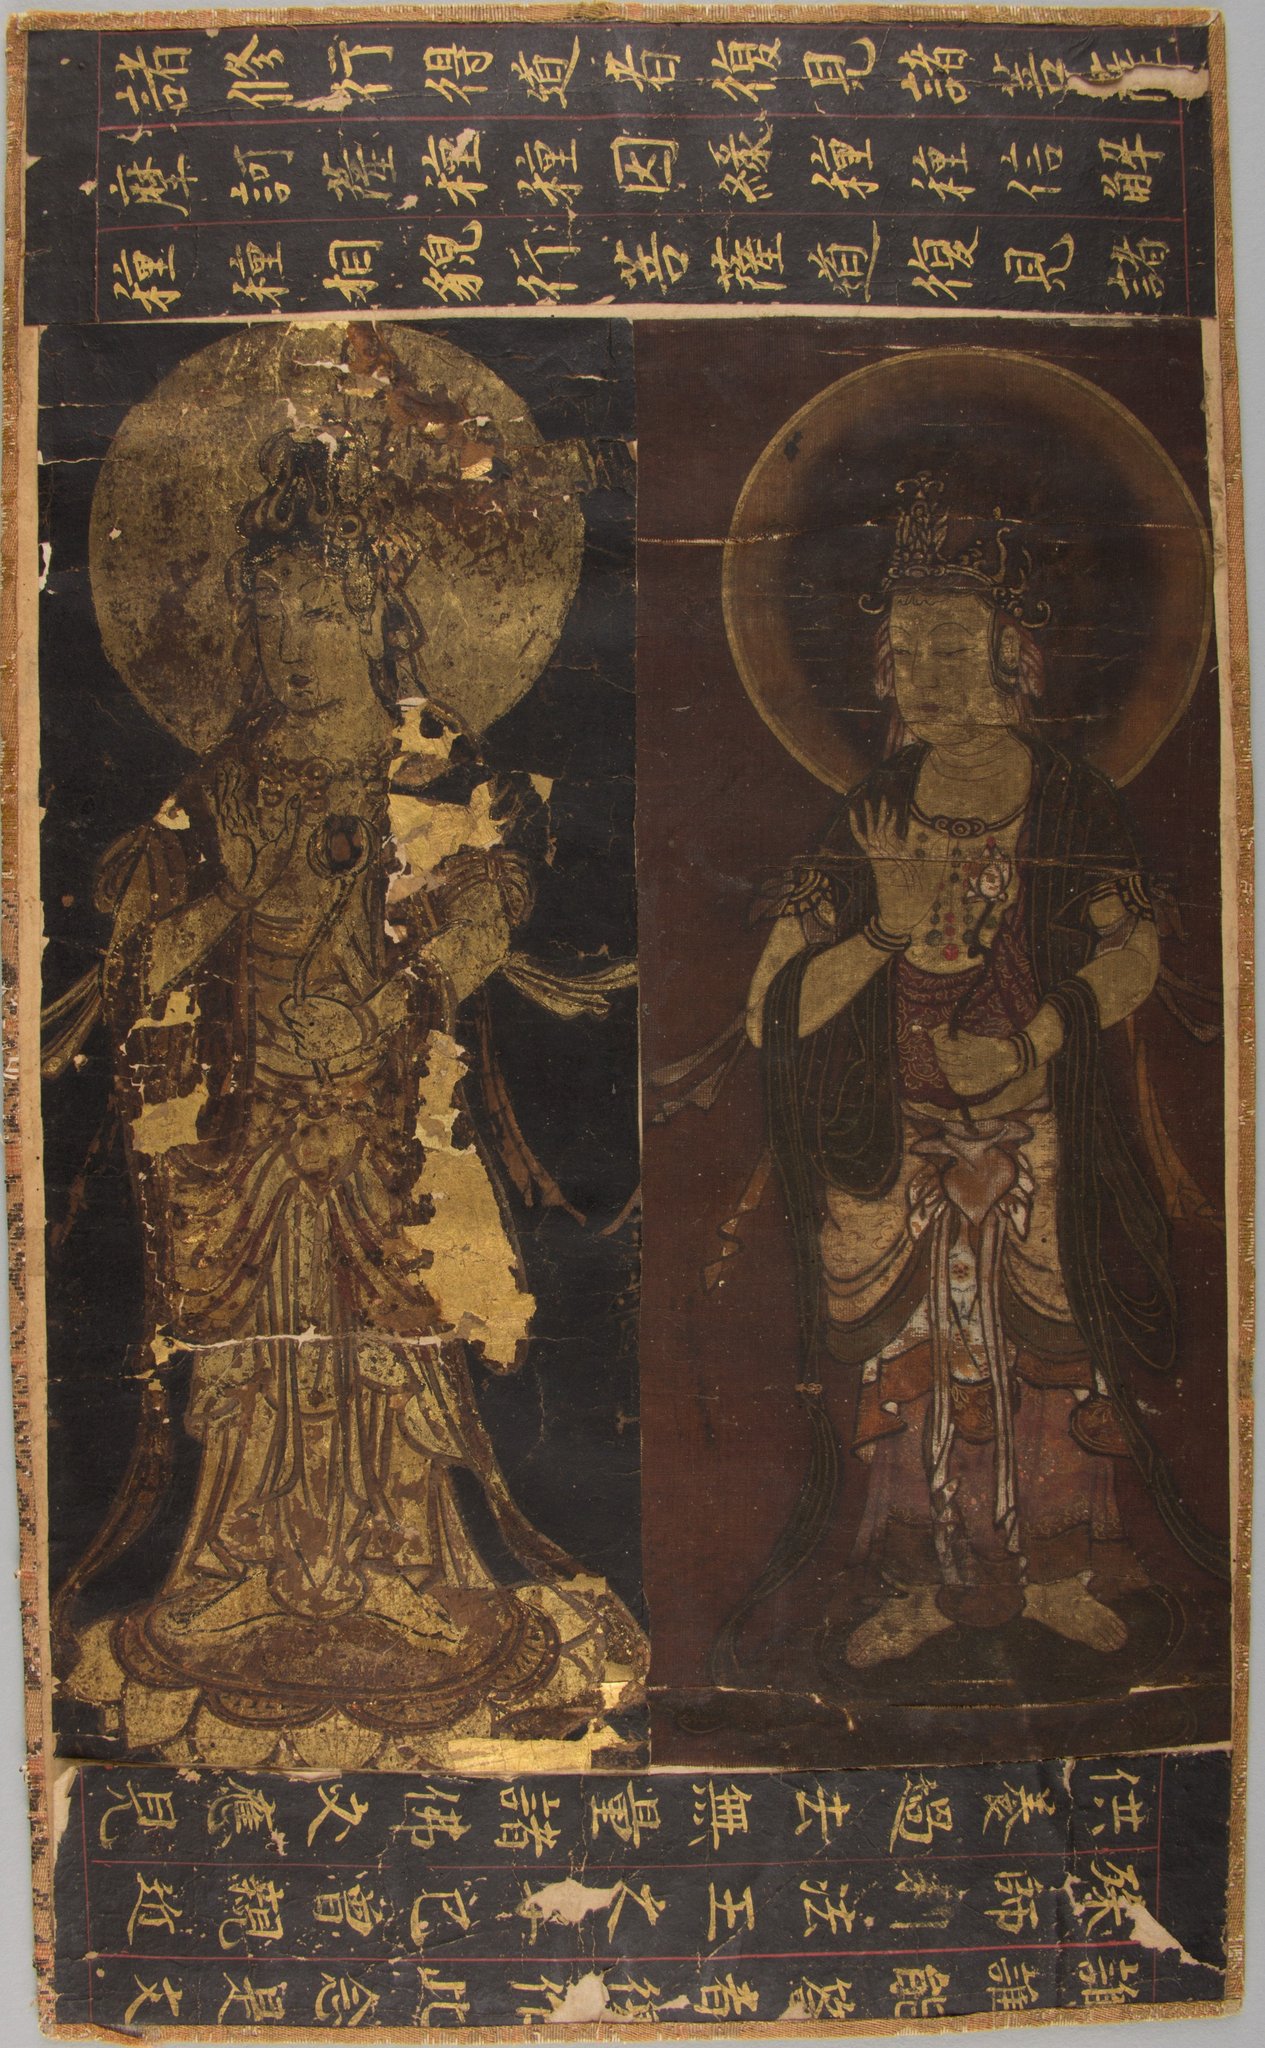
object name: book fragment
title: Page of a Pilgrim’s Visiting Album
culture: japanese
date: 1767-1900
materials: gold, ink, paper, textile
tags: buddhism,avalokiteshvara,buddha